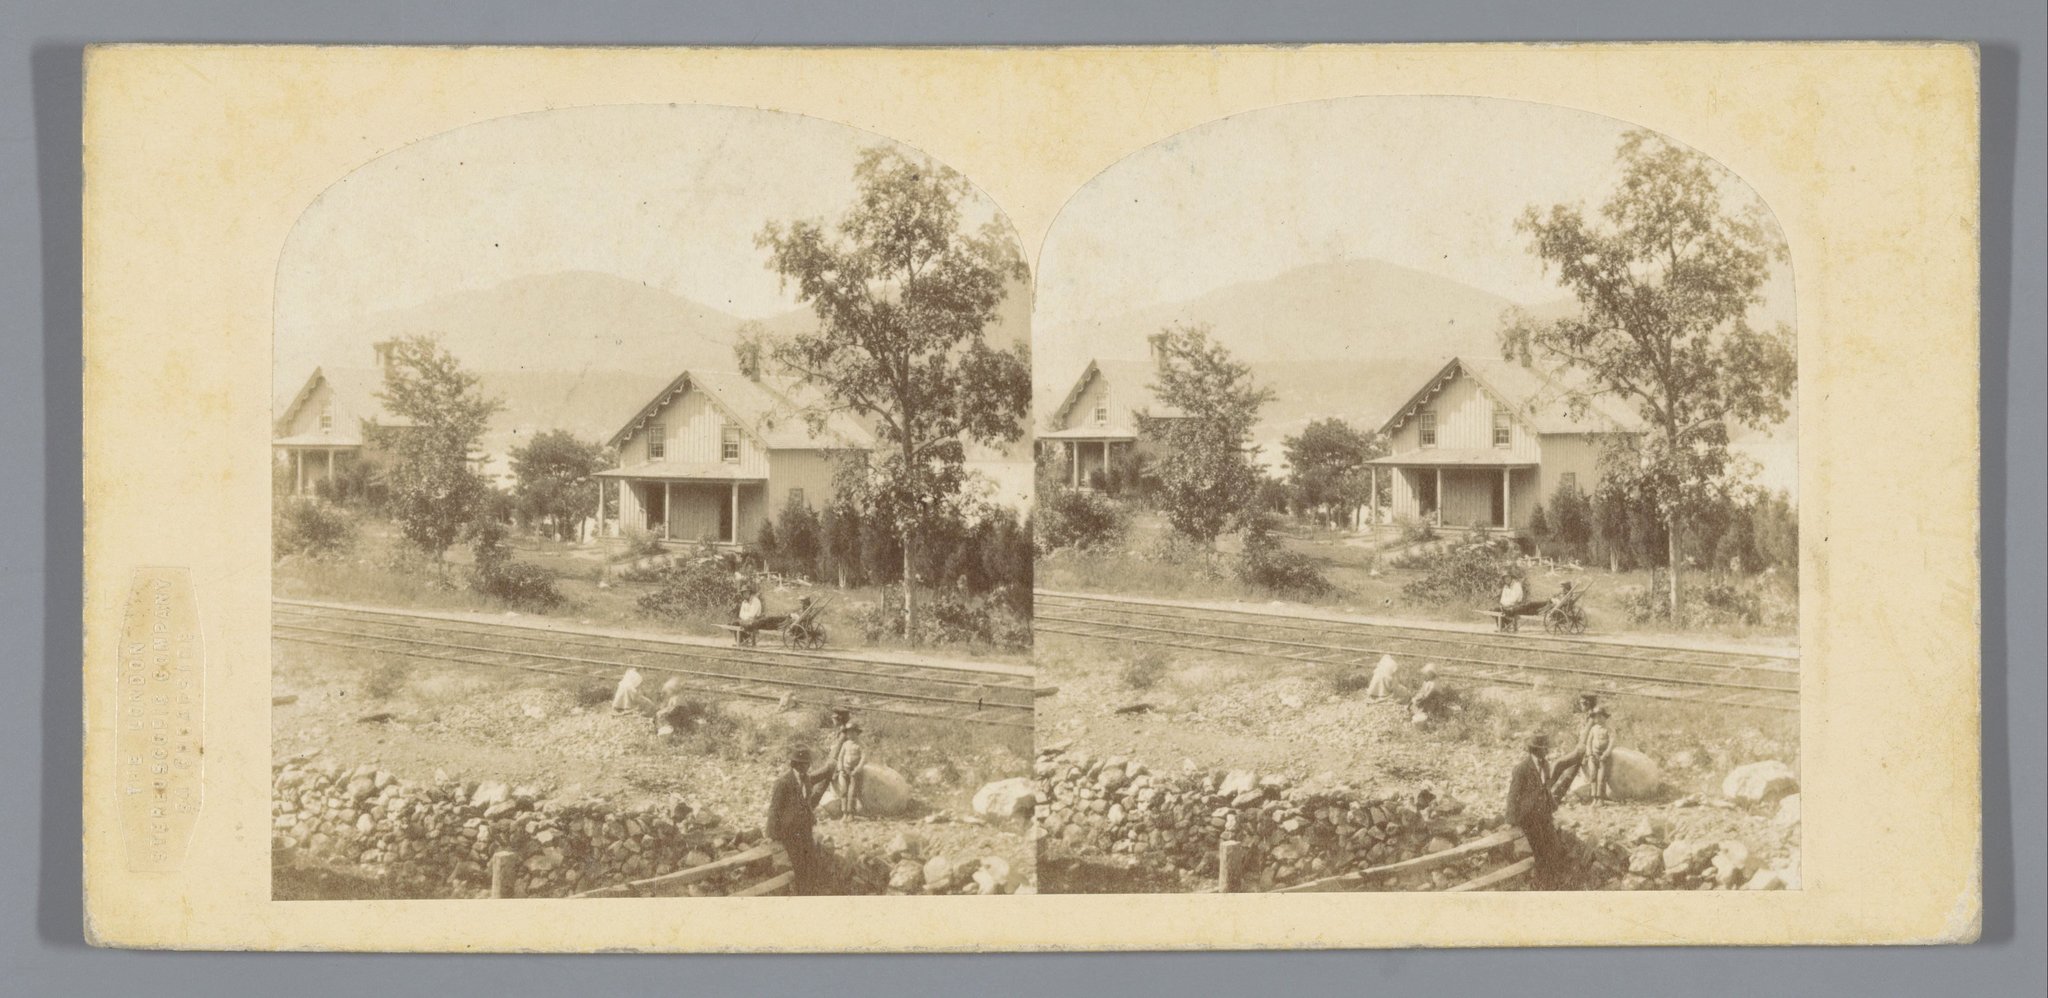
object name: stereograph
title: United States of America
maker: william england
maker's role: fotograaf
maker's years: 1816-1896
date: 1859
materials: cardboard, paper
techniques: albumen print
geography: london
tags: cottage, rural life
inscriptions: : ‘"Around this peaceful (...) a king's estate."’